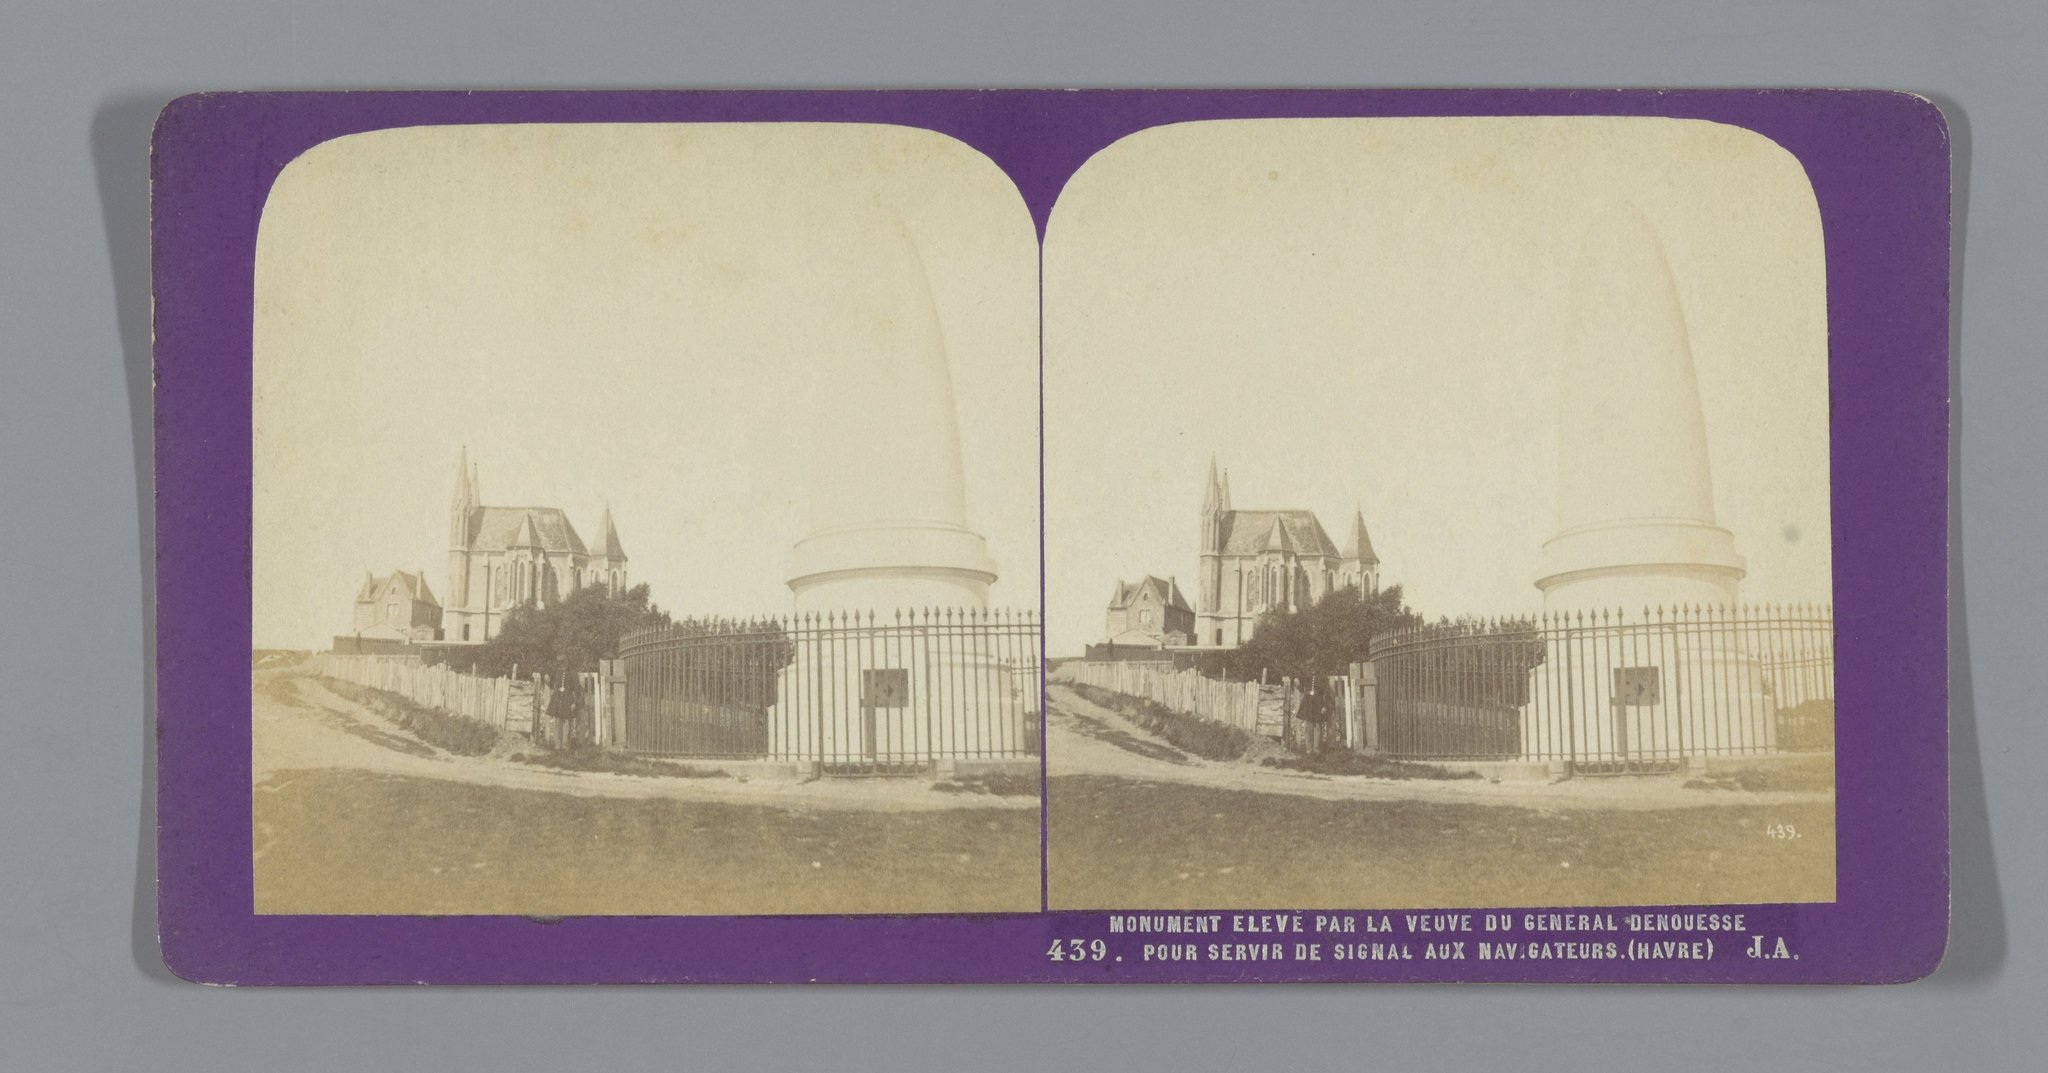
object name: stereograph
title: Monument te Le Havre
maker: jean andrieu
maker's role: fotograaf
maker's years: 1816-1872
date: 1862-1876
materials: cardboard, photographic support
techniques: albumen print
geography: le havre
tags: monument, statue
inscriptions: number: ‘439.’